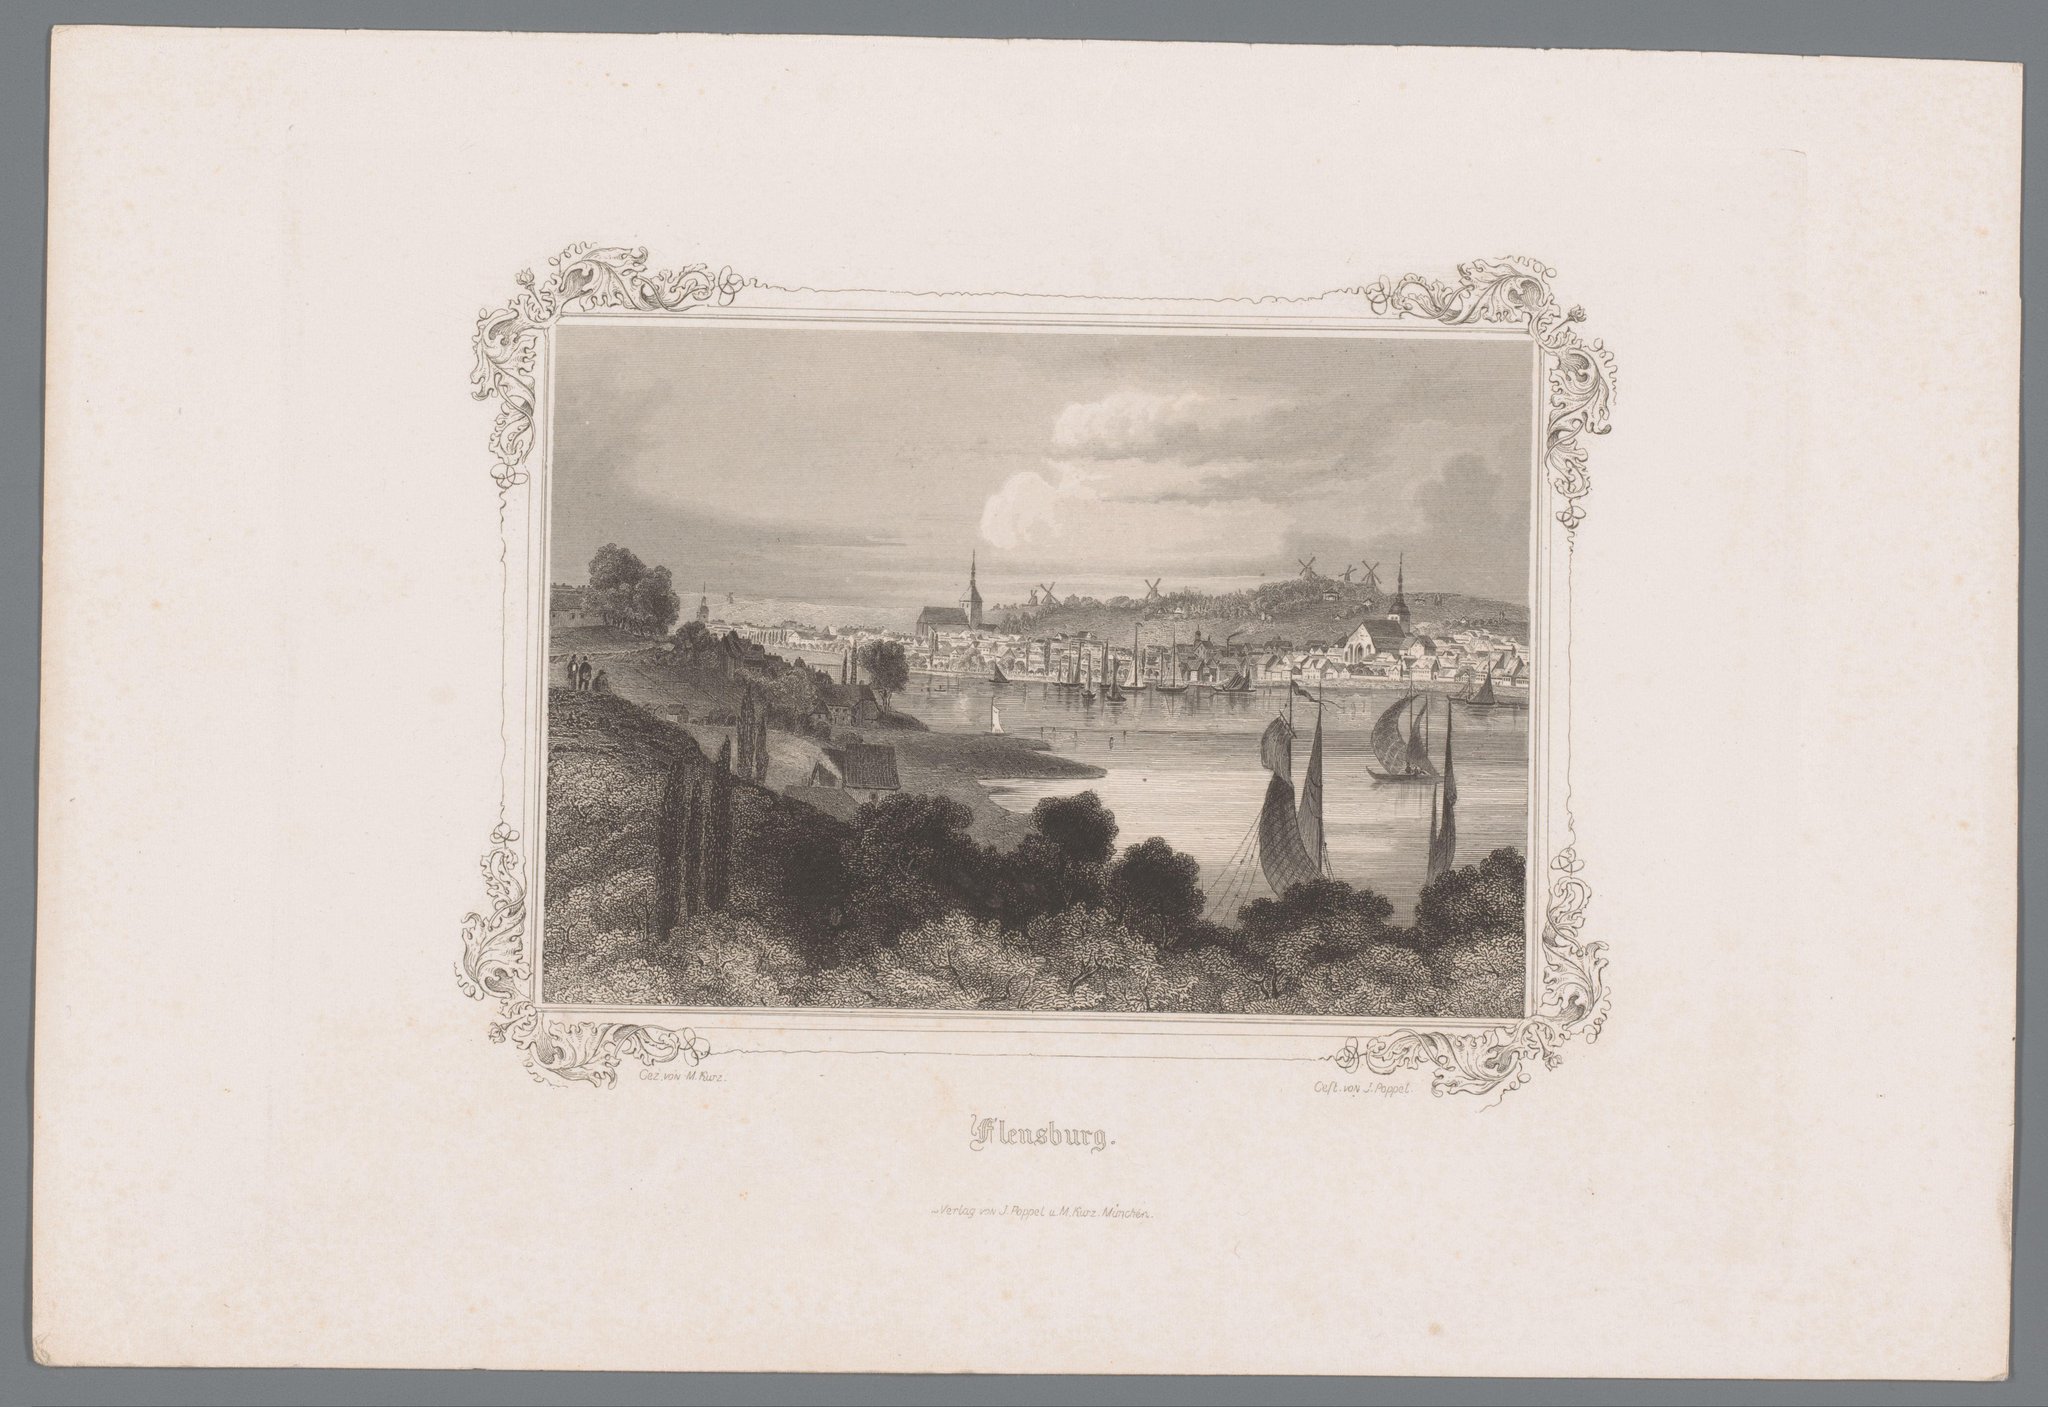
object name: print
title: Landschappen in Sleeswijk-Holstein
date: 1847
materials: paper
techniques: engraving, etching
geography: munich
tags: city-view in general; 'veduta' (+ city(-scape) with figures, staffage)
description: Deze prent behoort tot deel één of twee van de serie 'Landschappen in Sleeswijk-Holstein'. Het betreft een vierdelige reeks uitgegeven in twee omslagen waarvan deze omslag deel één en twee bevat met daarin zes landschappen en zes tekstbladen.